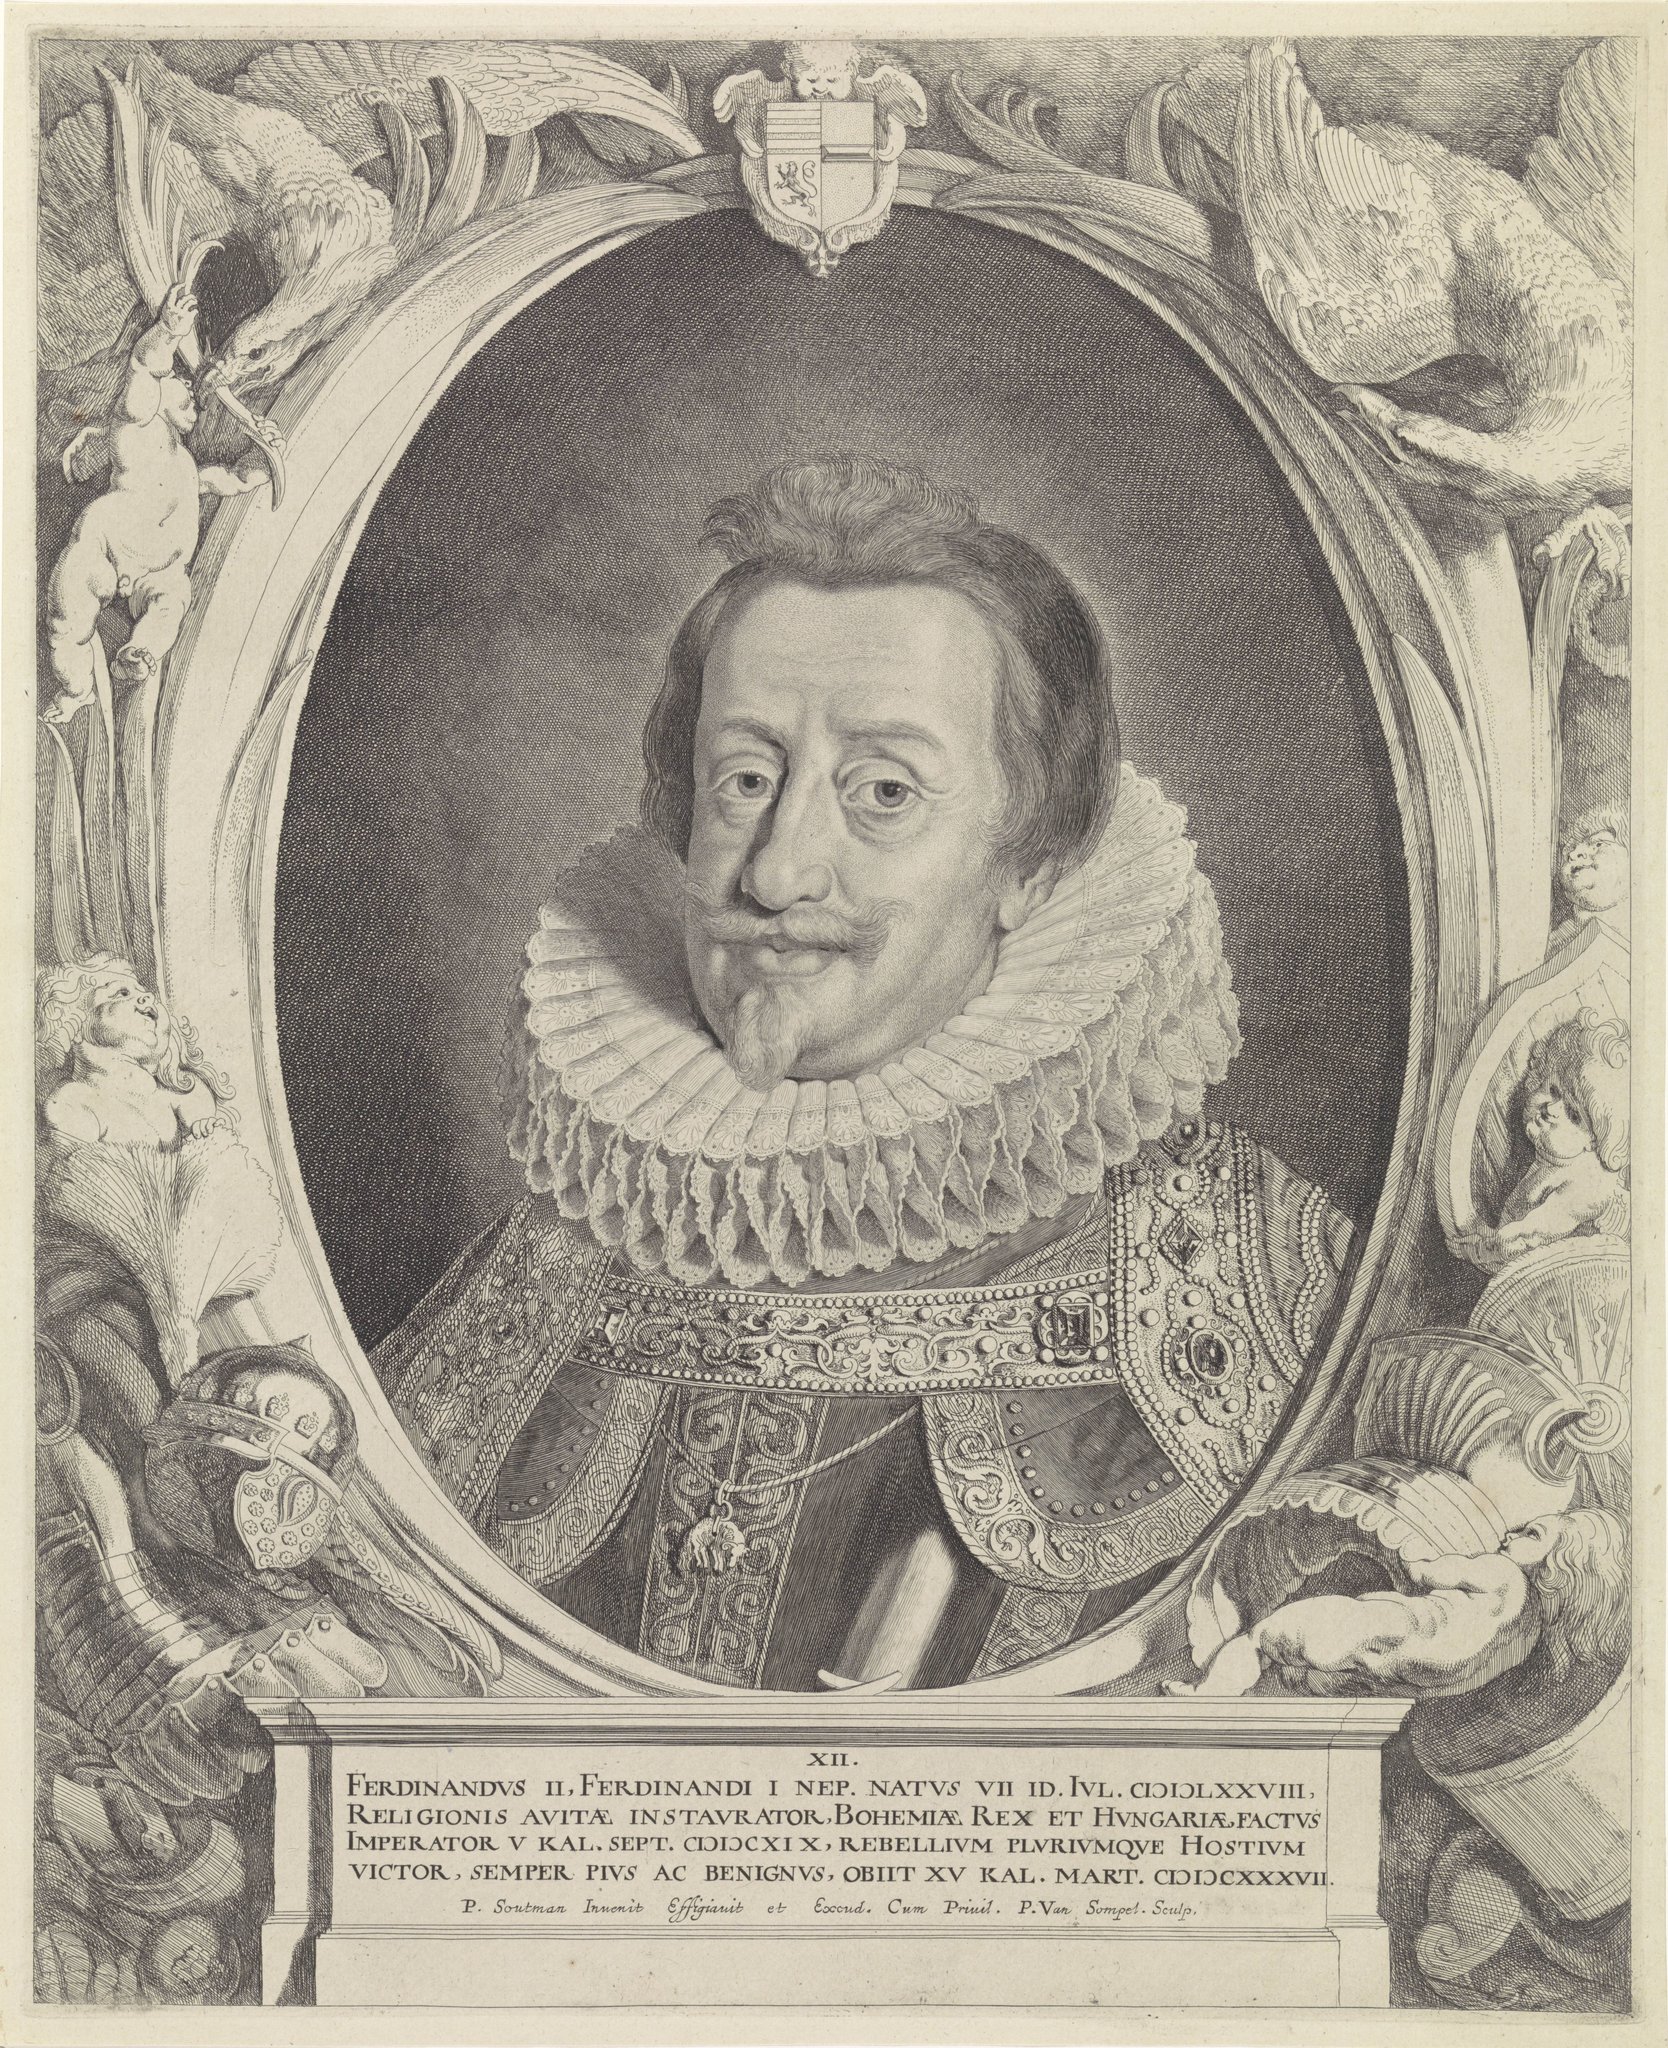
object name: print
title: Portret van Ferdinand II (Duits keizer)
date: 1644-1650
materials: paper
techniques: engraving, etching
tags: vienna, ferdinand ii (duits keizer), knighthood order of the golden fleece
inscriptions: collector's mark: Lugt 2228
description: Portret van Ferdinand II (Duits keizer). Hij draagt een koord met de versierselen van de Orde van het Gulden Vlies. Het portret wordt omlijst door een randversiering met putti en harnasonderdelen. In de beide bovenhoeken een adelaar, in het midden zijn wapenschild. Onder het portret een cartouche met in het Latijn zijn naam, titels en een korte levensbeschrijving. Genummerd "XII".